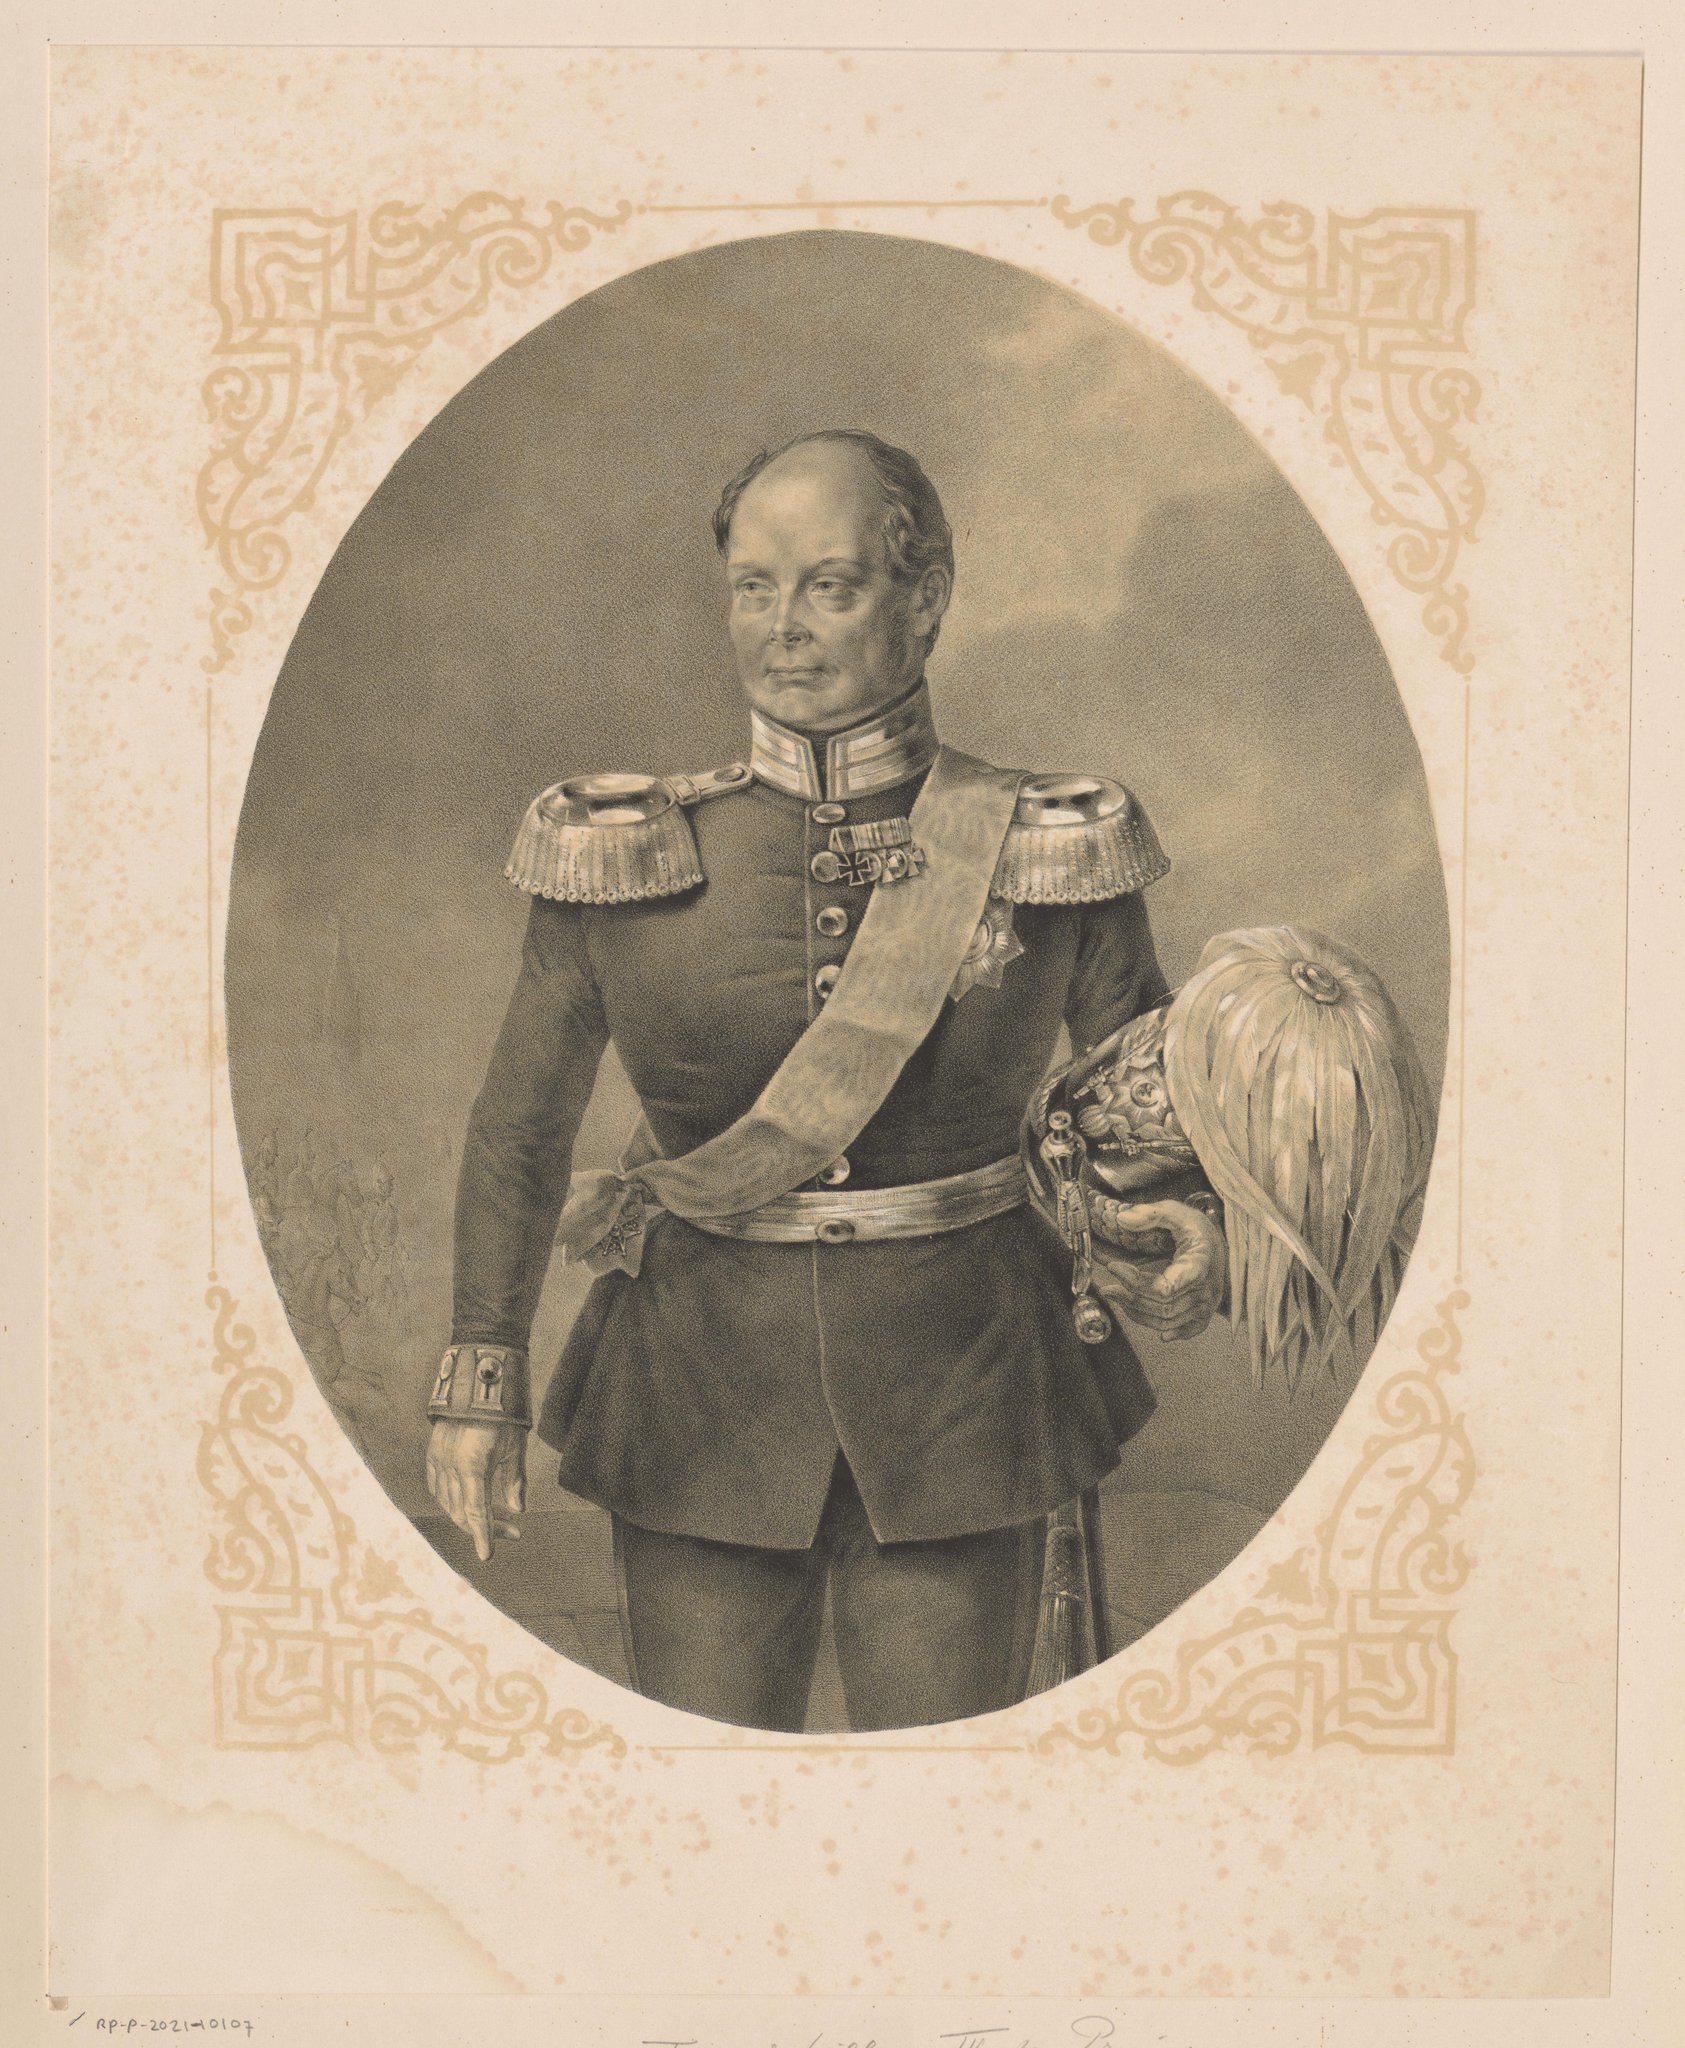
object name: print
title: Portret van Frederik Willem IV van Pruisen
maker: Anonymous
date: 1840-1861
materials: paper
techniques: tone lithography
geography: germany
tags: berlin, frederik willem iv (koning van pruisen), historical persons, (military) uniforms, king